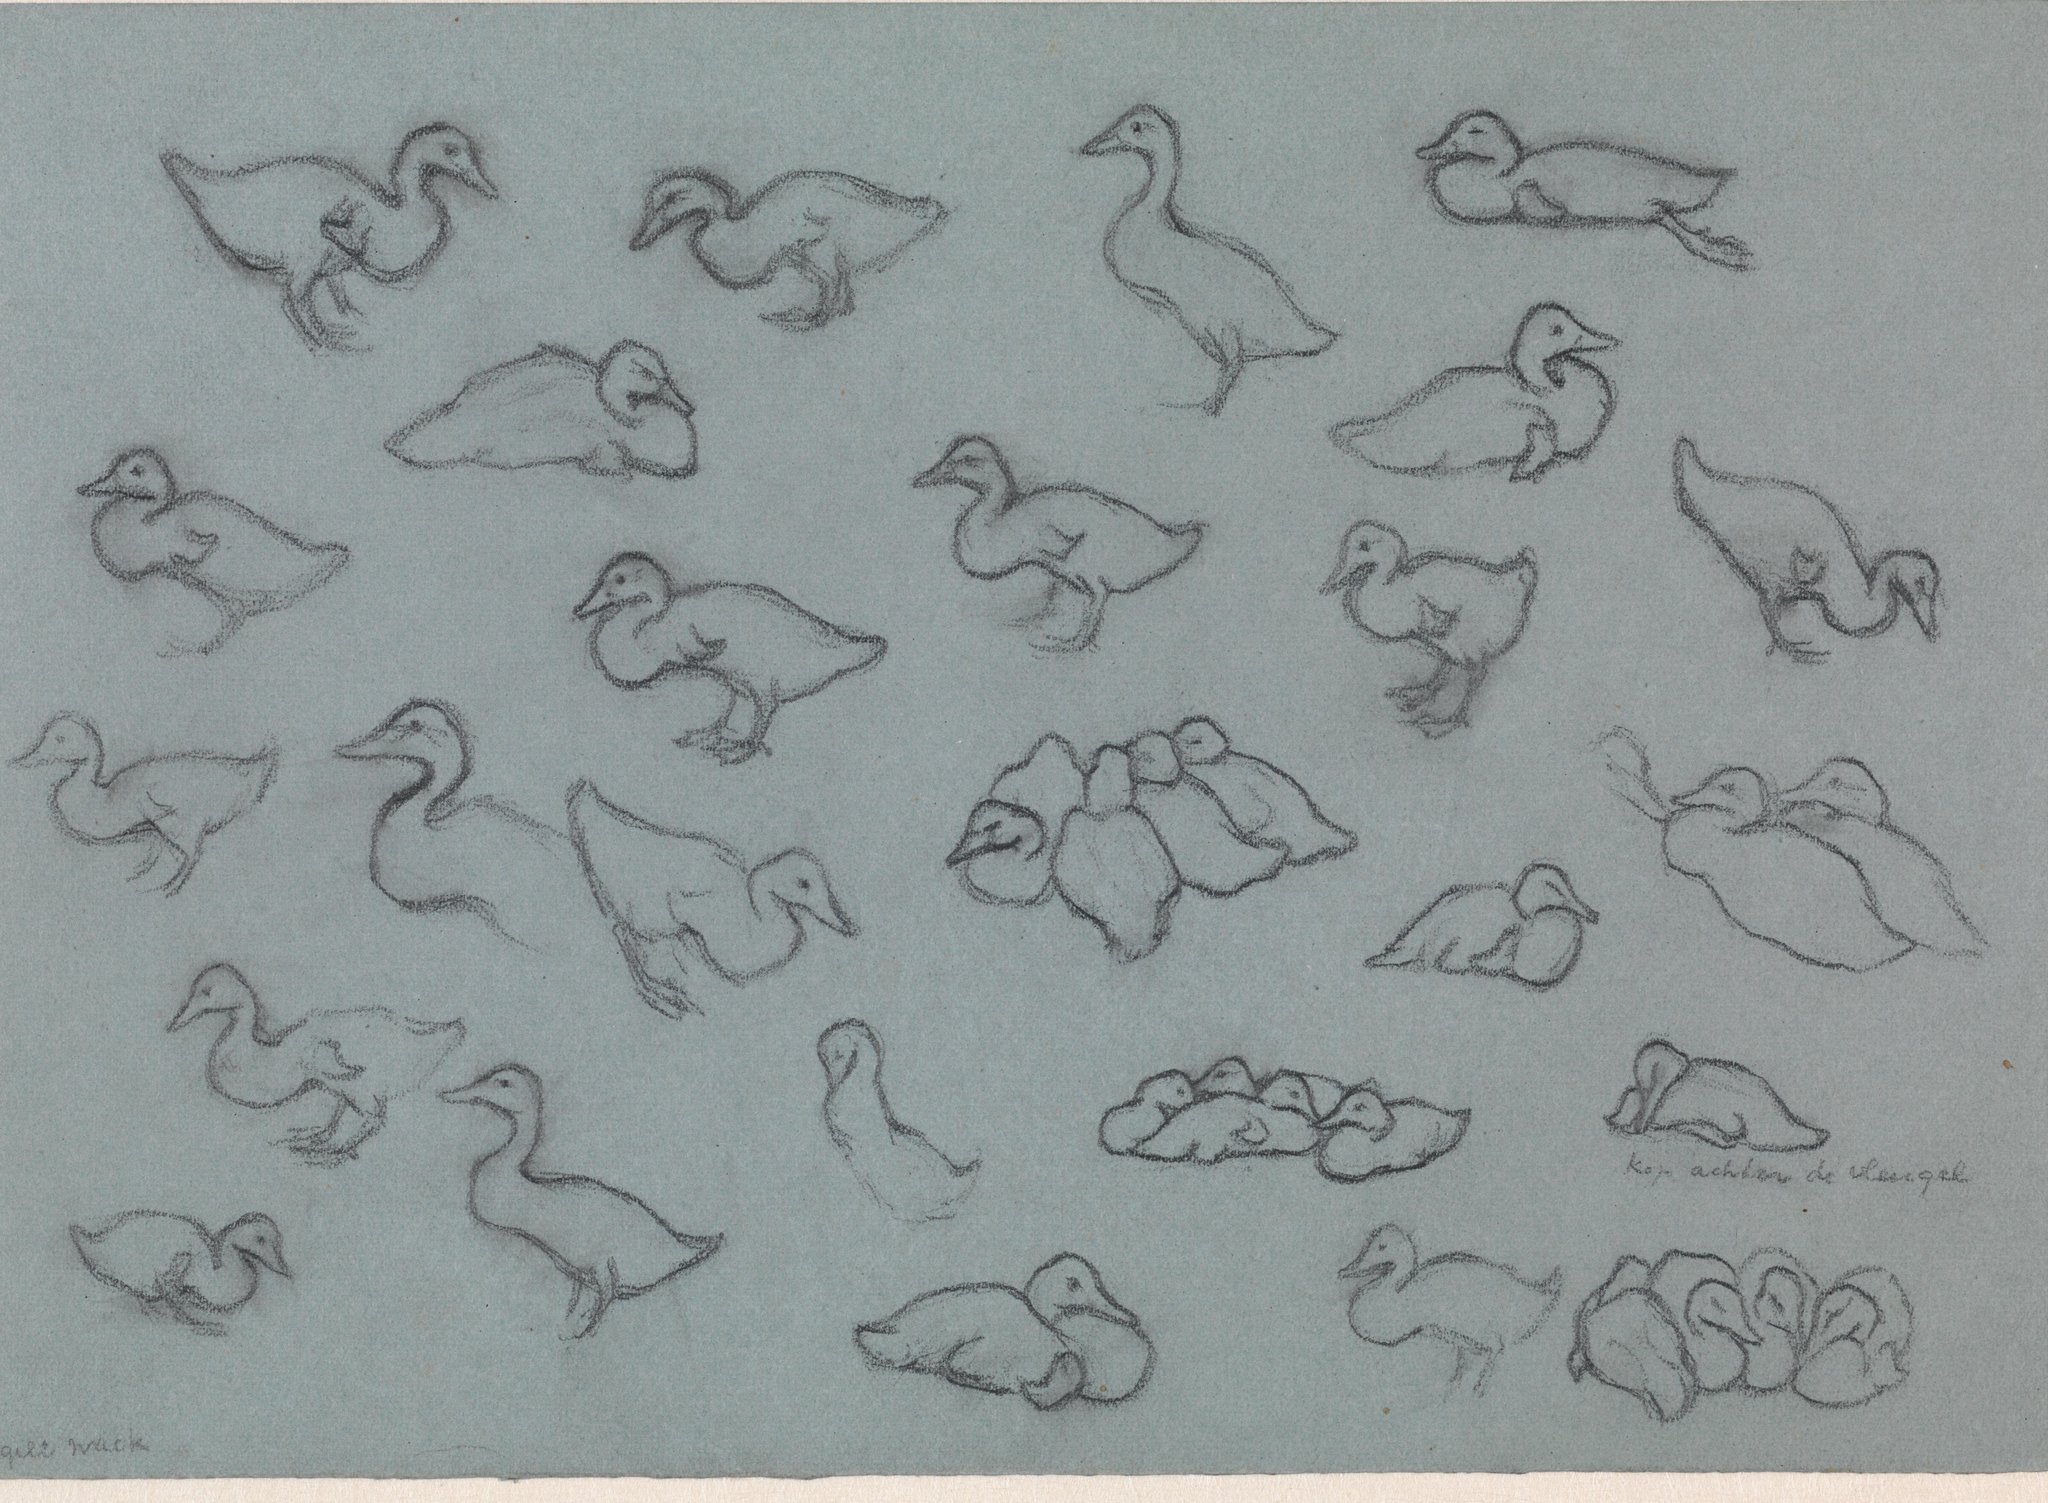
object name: drawing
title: Studieblad met eenden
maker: julie de graag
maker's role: draughtsman, print maker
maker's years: 1877-1924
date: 1887-1924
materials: paper, pencil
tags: ducks (domestic waterbirds)